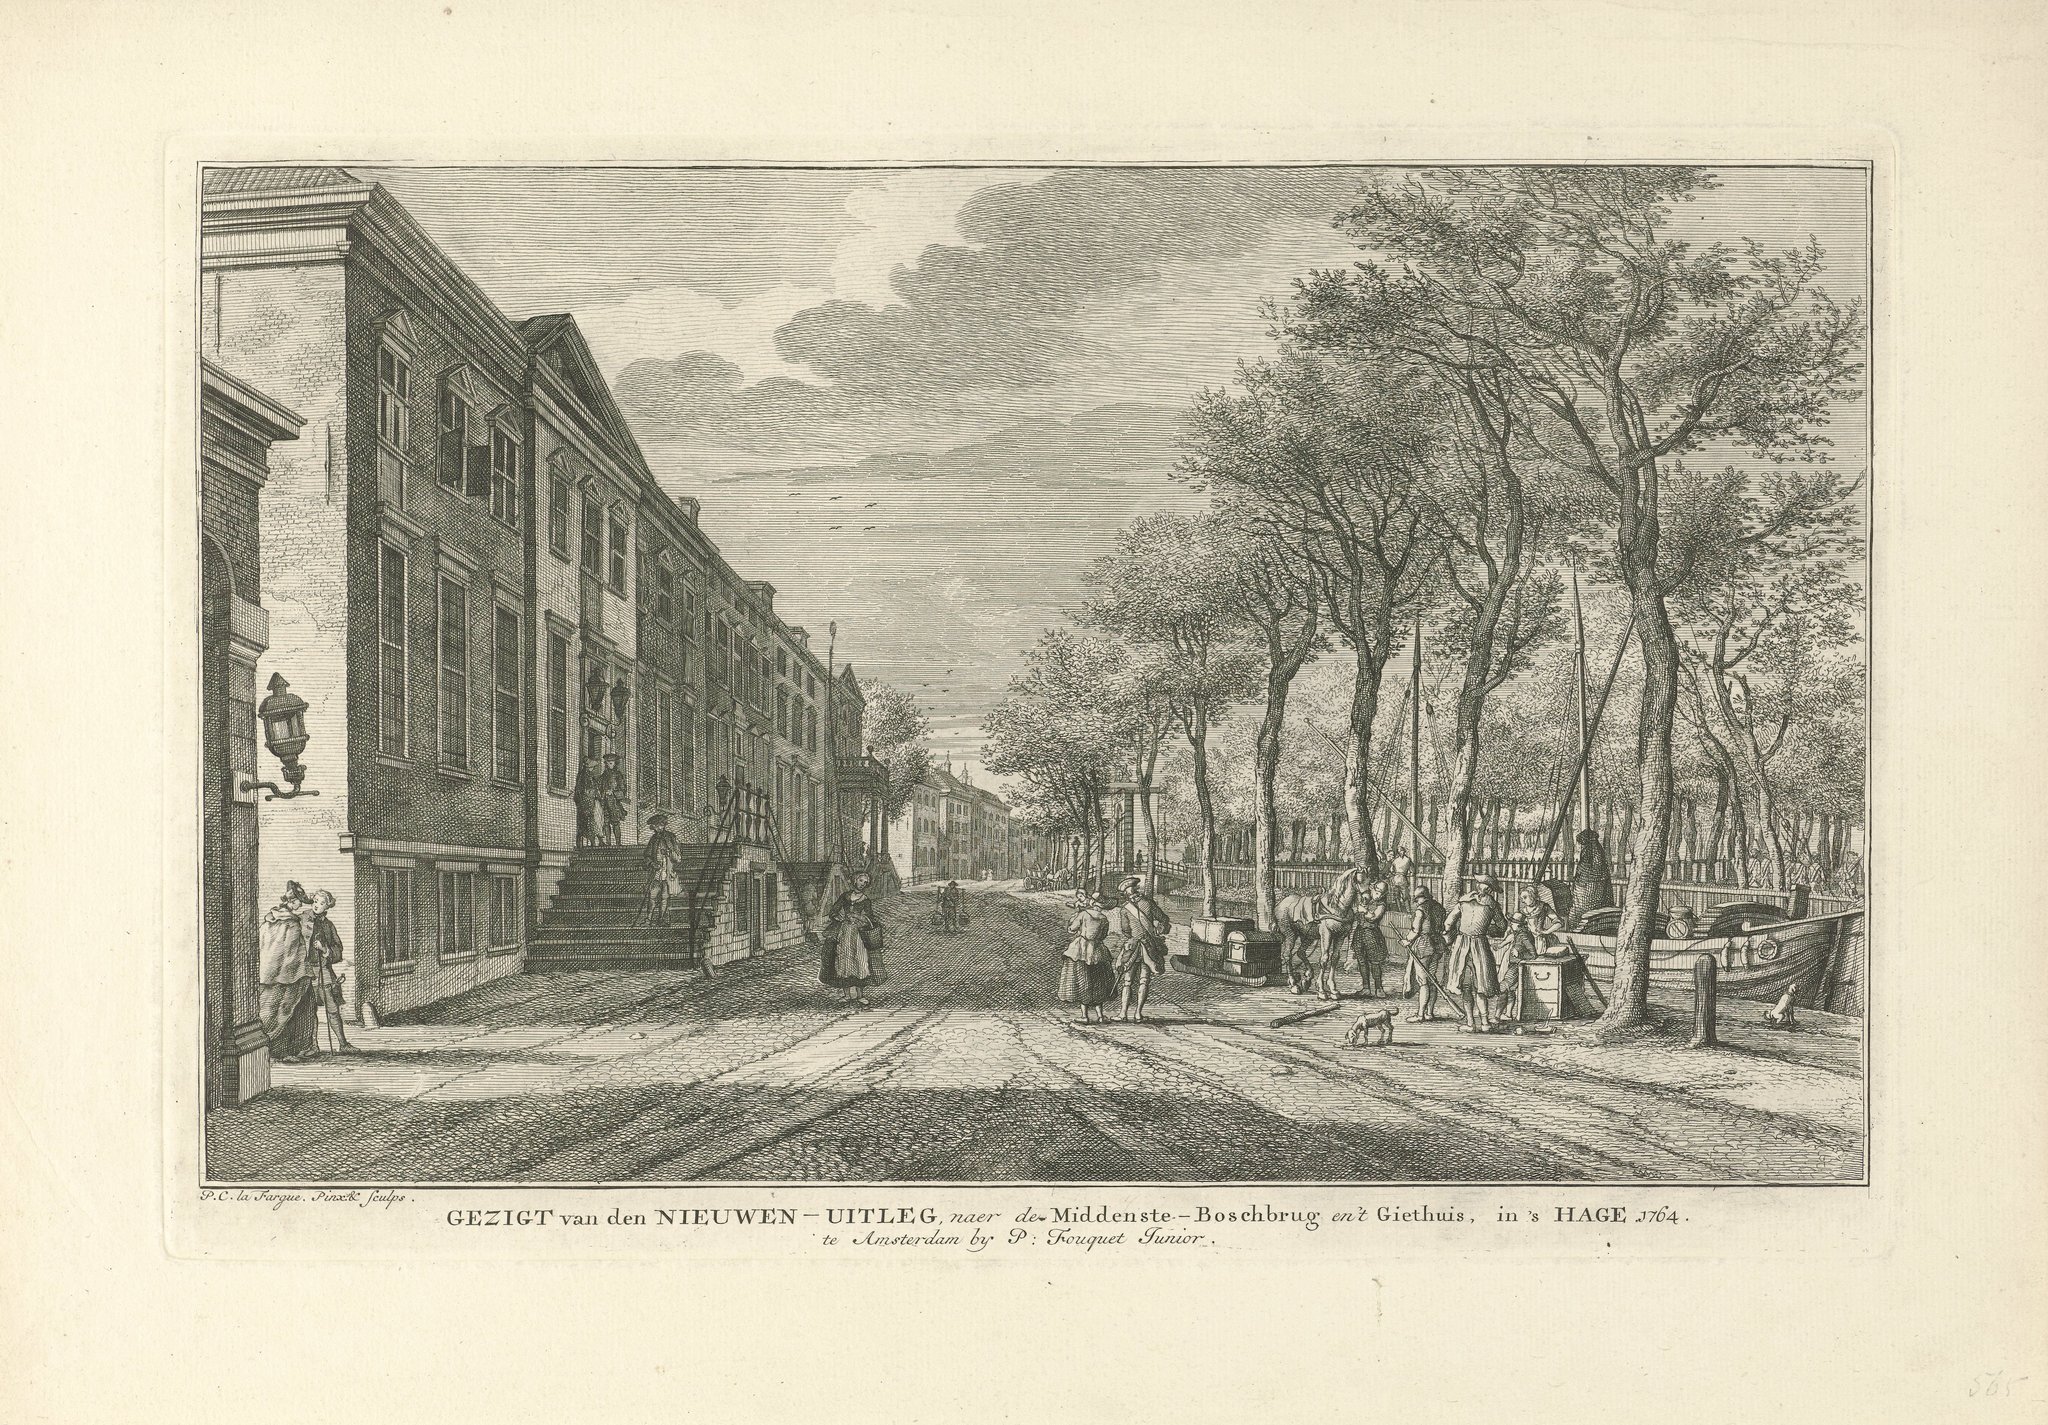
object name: print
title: Gezicht op de Prinsessegracht te Den Haag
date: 1764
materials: paper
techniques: engraving, etching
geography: the hague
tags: city-view, and landscape with man-made constructions, bridge in city across river, canal, etc., street (+ city(-scape) with figures, staffage)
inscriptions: collector's mark: Lugt 2228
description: Gezicht op de Prinsessegracht, gelegen op het 'eiland' de Nieuwe Uitleg, te Den Haag, gezien richting de Bosbrug en de hoek met het Korte Voorhout. Op de voorgrond links het gebouw van de Franse ambassade op de hoek met de Casuariestraat. Aan de overkant van de vaart rechts het park de Koekamp. Prent uit een serie van acht gezichten in Den Haag.